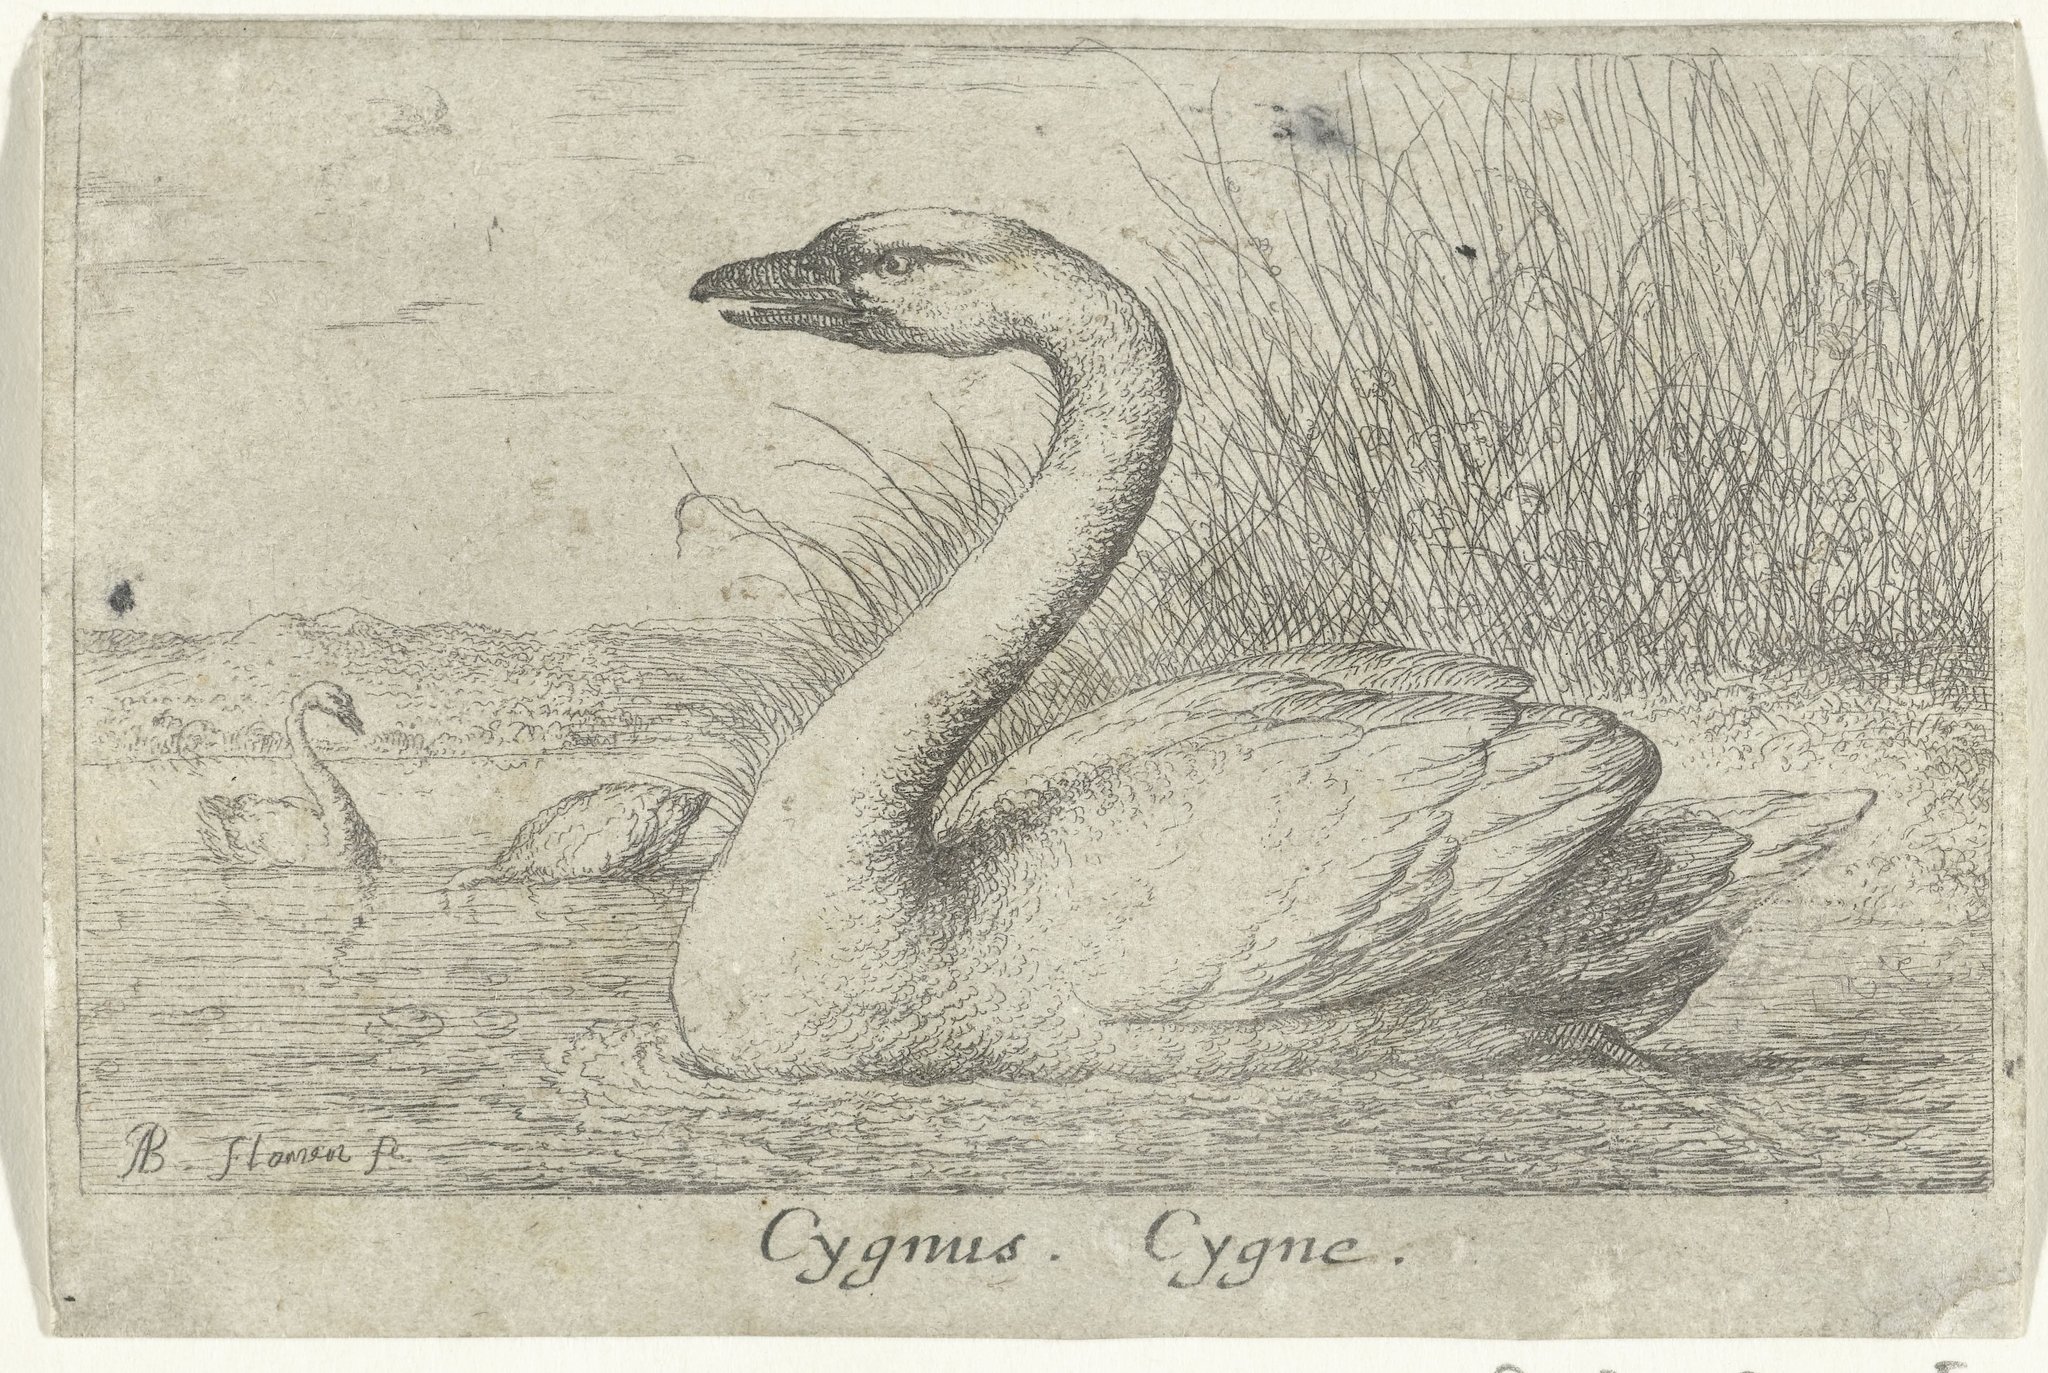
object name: print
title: Diuersae Auium Specie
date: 1659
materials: paper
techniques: etching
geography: paris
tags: water-birds: swan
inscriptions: collector's mark: Lugt 2228